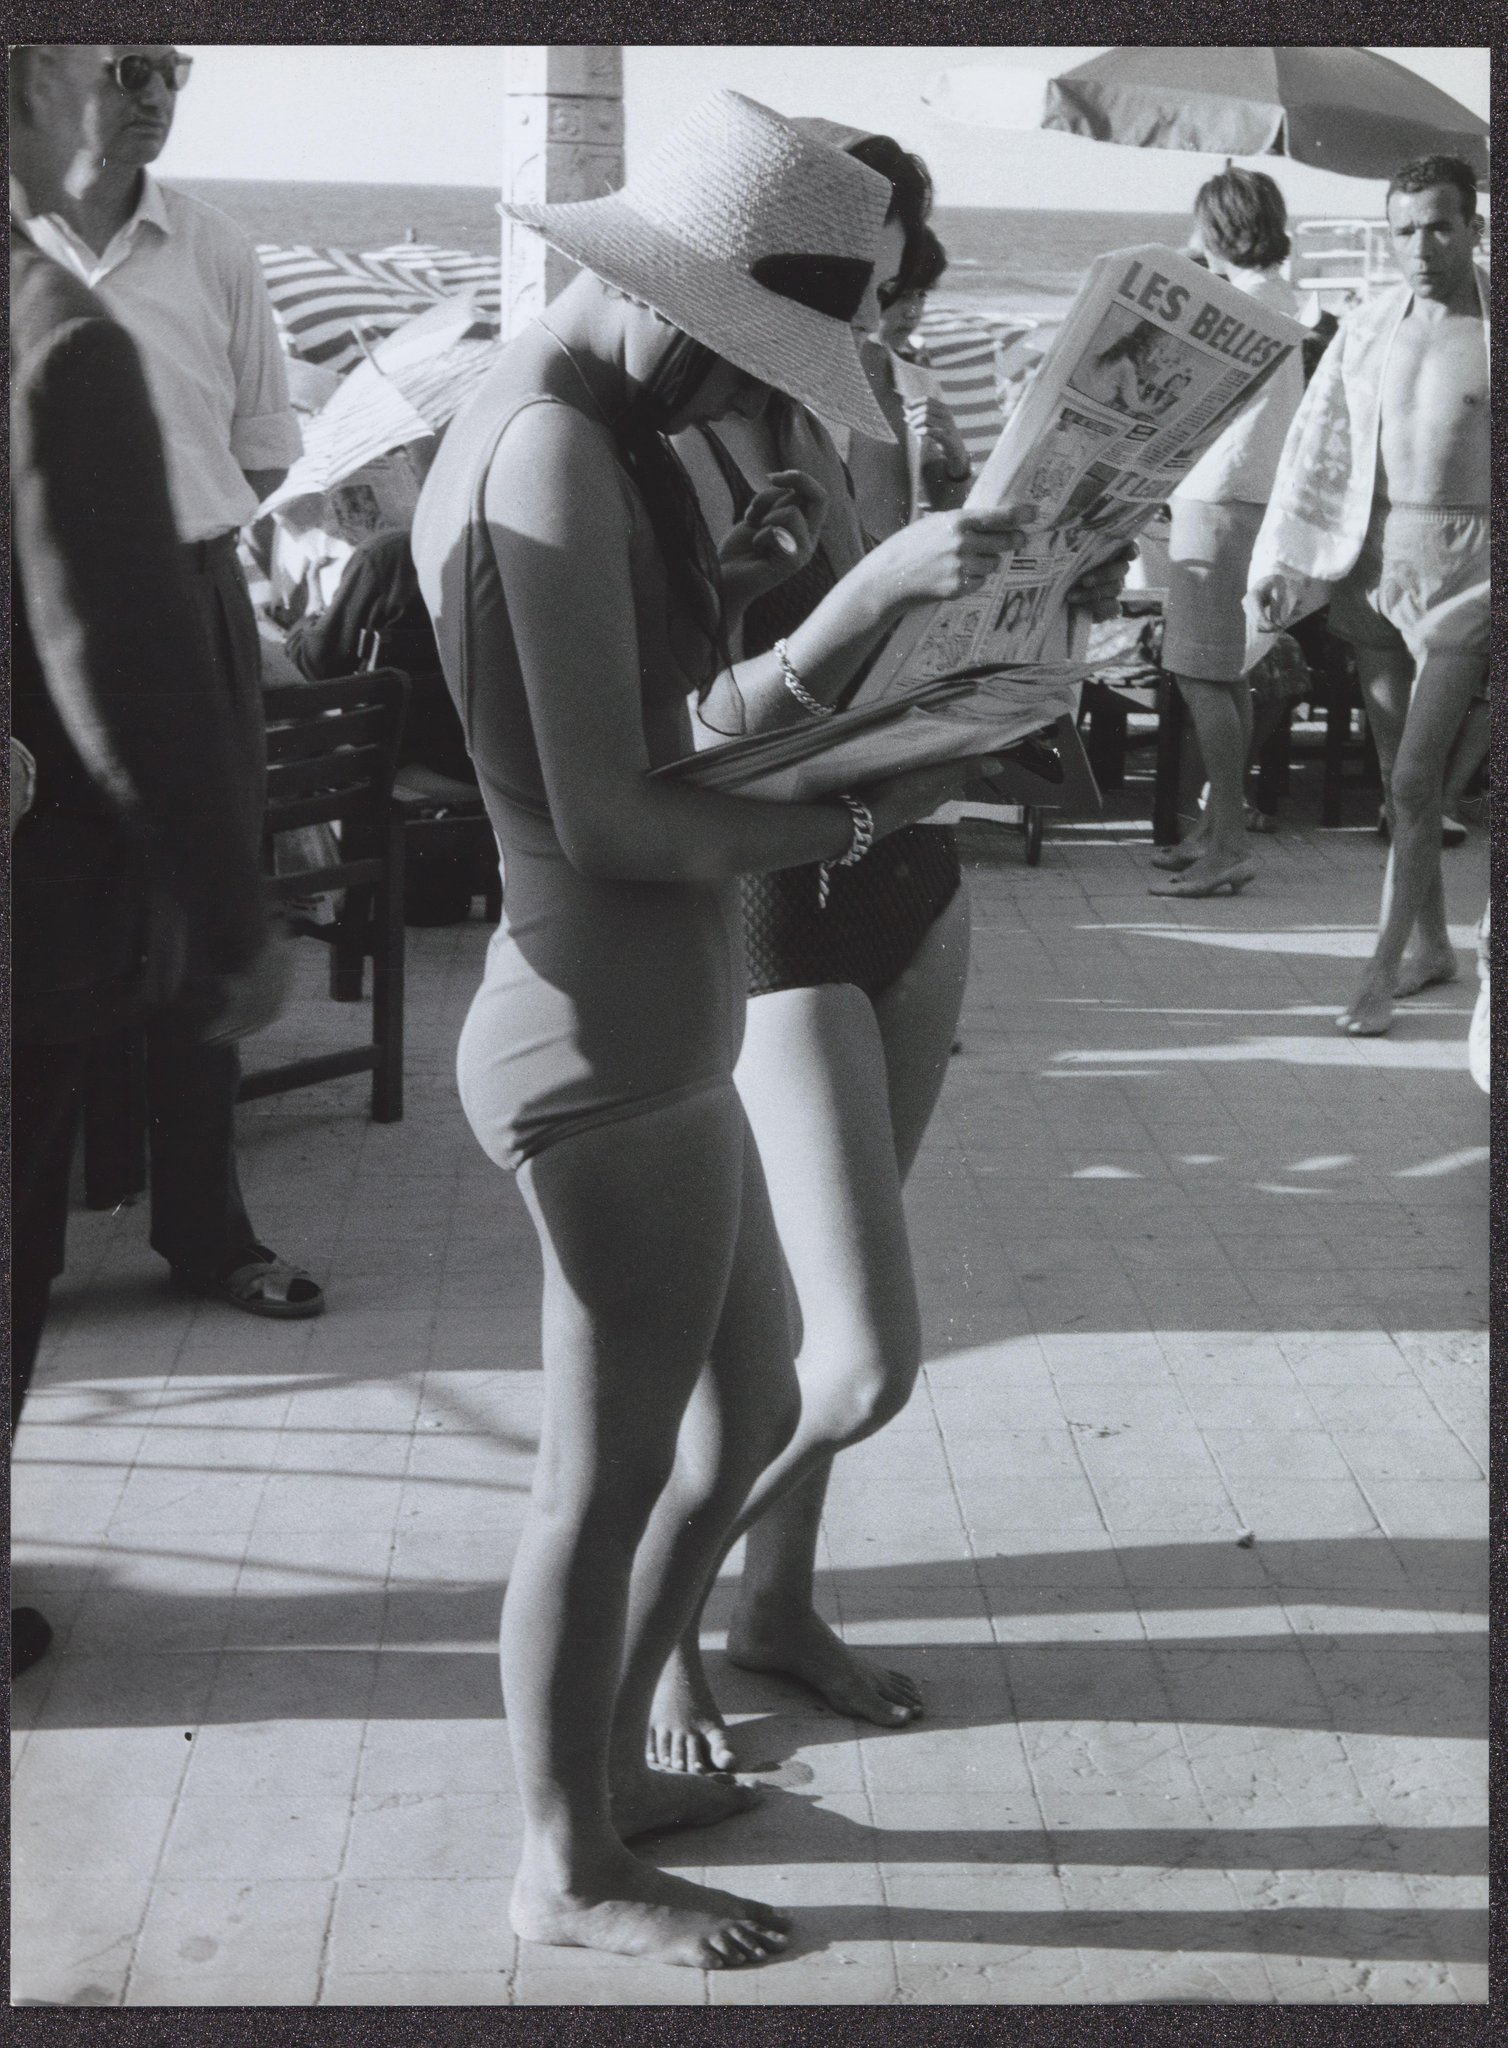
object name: photograph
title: Twee vrouwen in badkleding lezen de krant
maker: Anonymous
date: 1955-1970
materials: paper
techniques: gelatin silver print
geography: france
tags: beach (as place of recreation), reading, newspaper, news-sheet, france